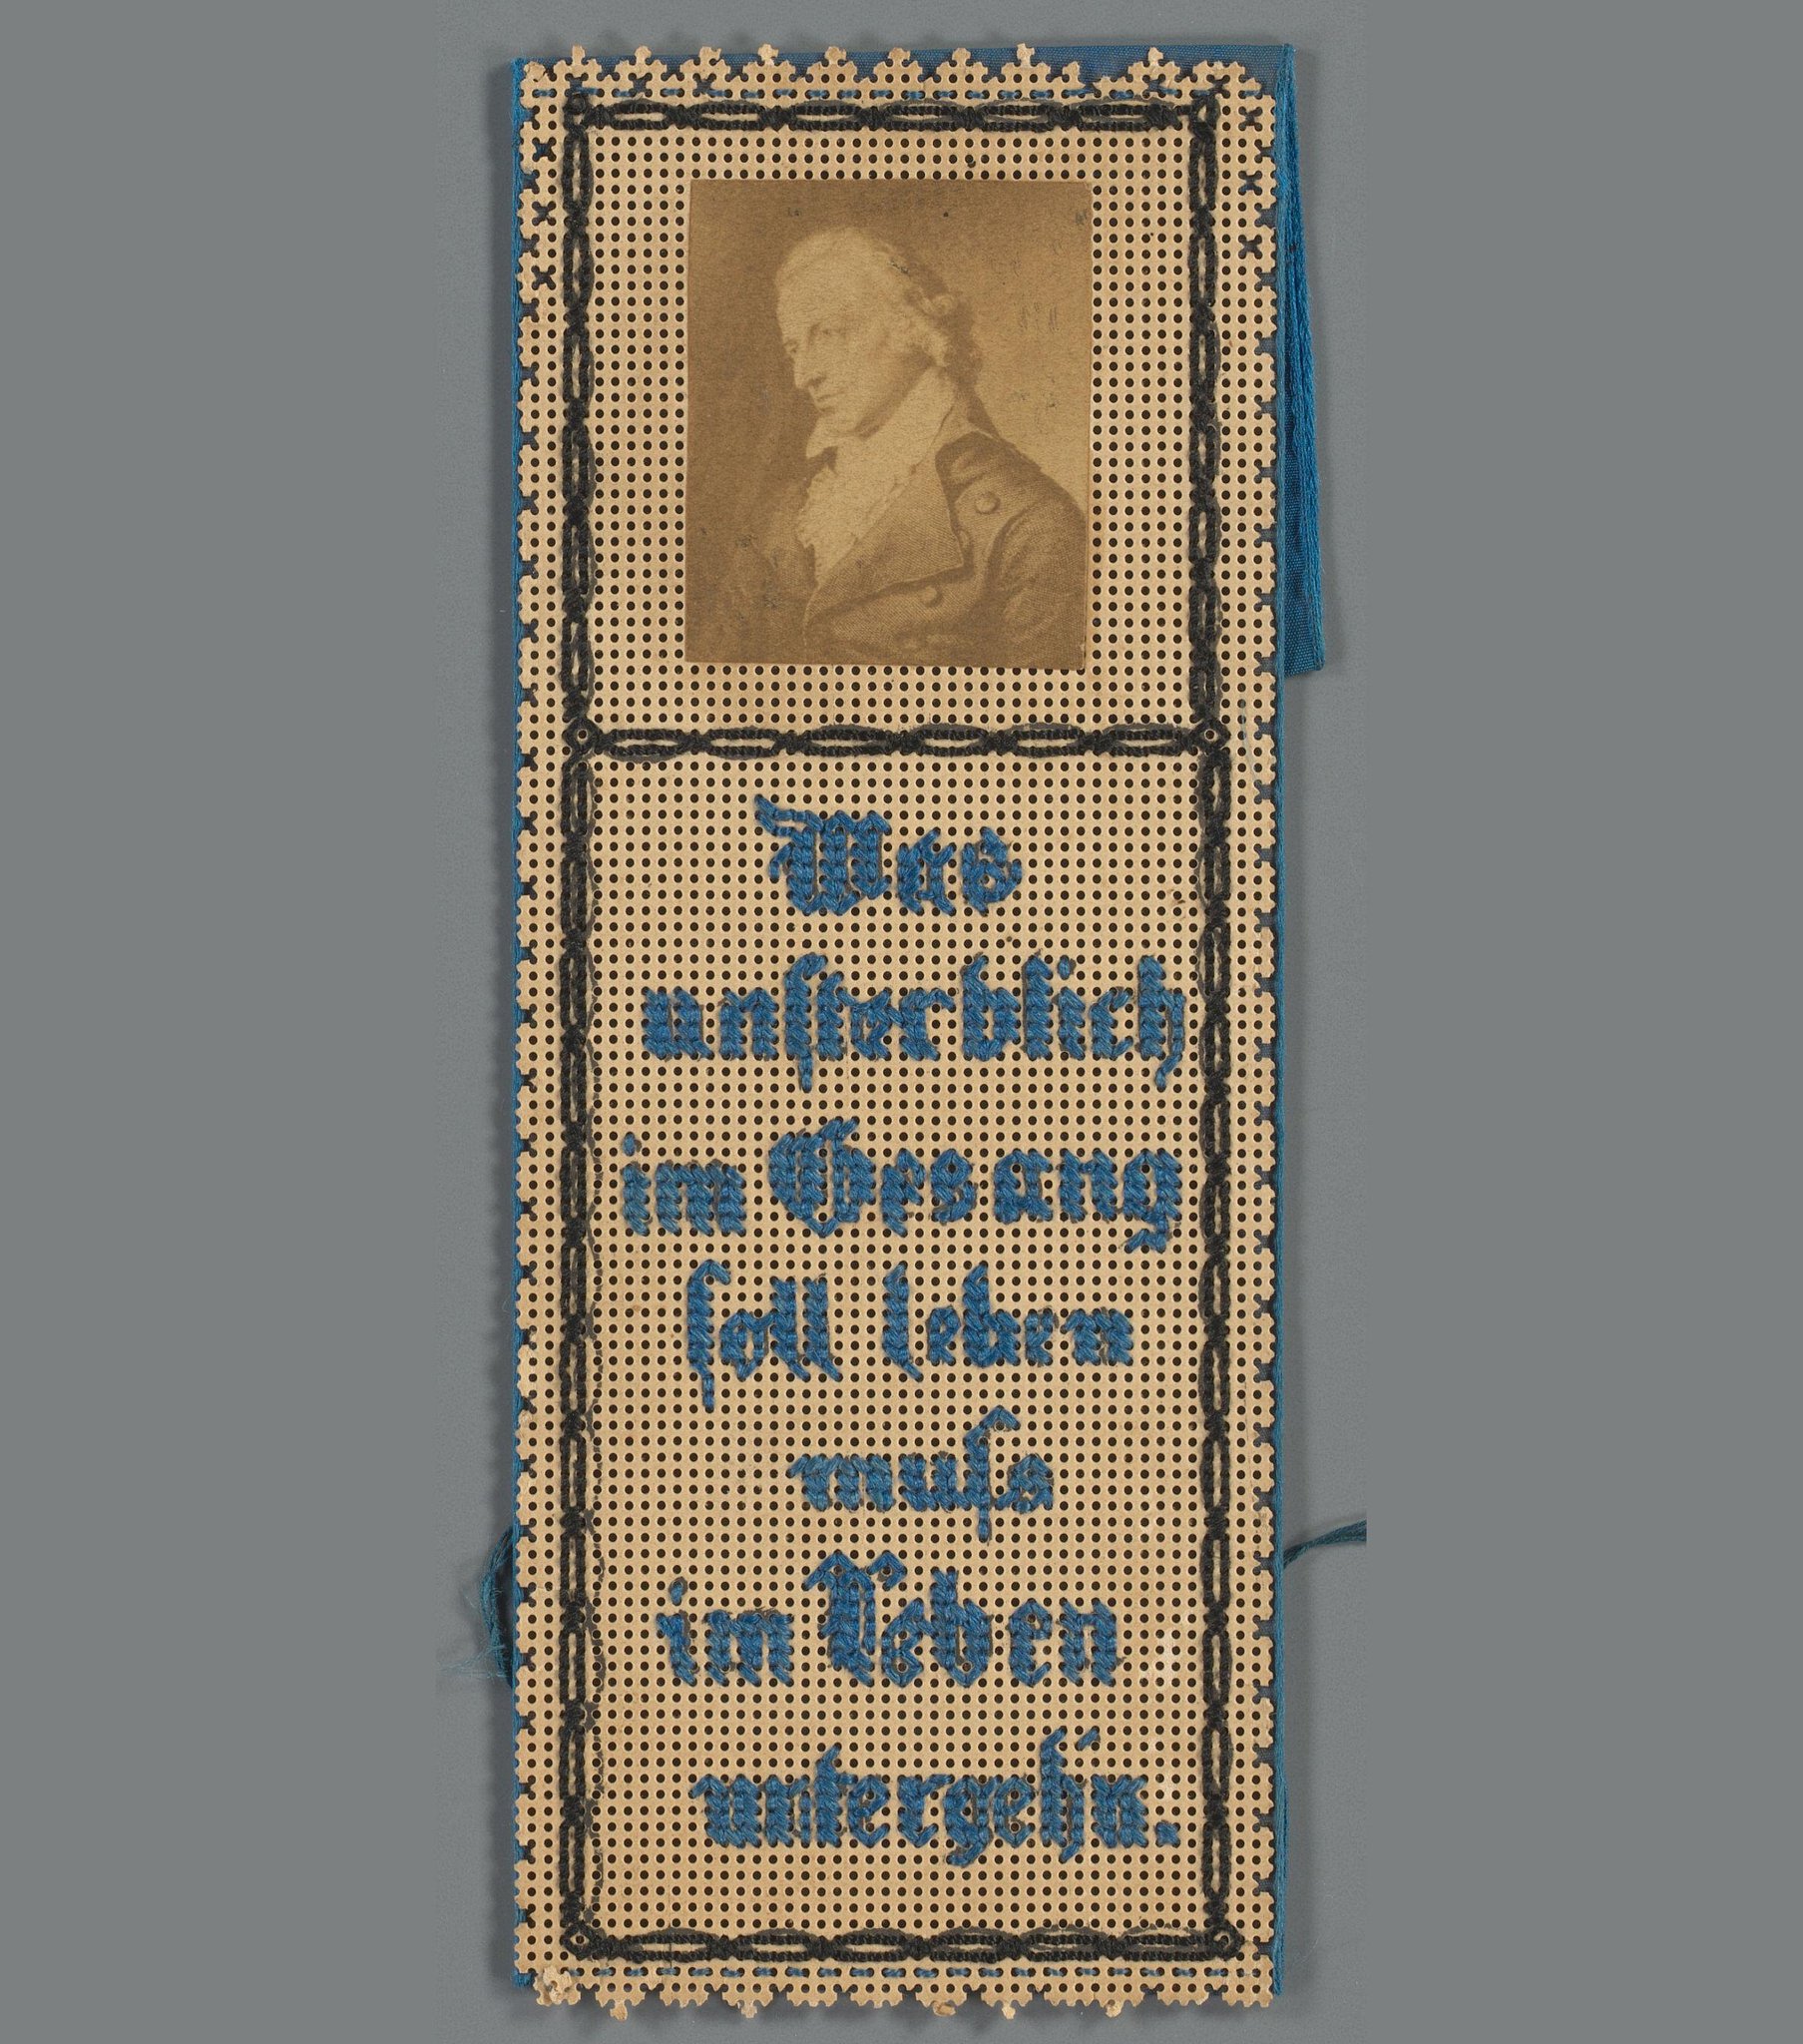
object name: photograph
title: Fotoreproductie van een gegraveerd portret van een onbekende man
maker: Anonymous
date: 1851-1900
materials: cardboard, paper, textile, yarns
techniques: albumen print, embroidered, perforating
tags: print, e.g.: engraving, etching, lithograph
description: Boekenlegger met geborduurde tekstpassage uit Die Götter Griechenlandes van Friedrich Schiller: 'Was unsterblich im Gesang soll leben, muss im Leben untergehn'.